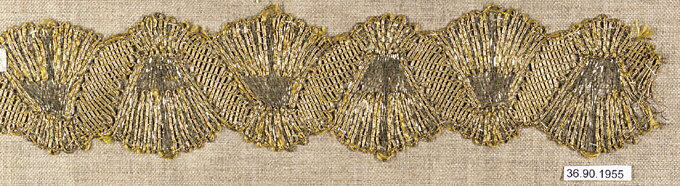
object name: piece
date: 1801-1900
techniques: lace